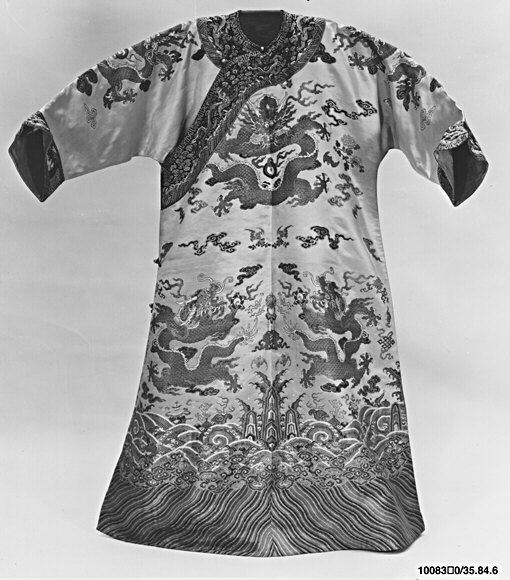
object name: robe, imperial court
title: Imperial Court Robe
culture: chinese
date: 1701-1733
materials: metal thread, silk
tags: dragons